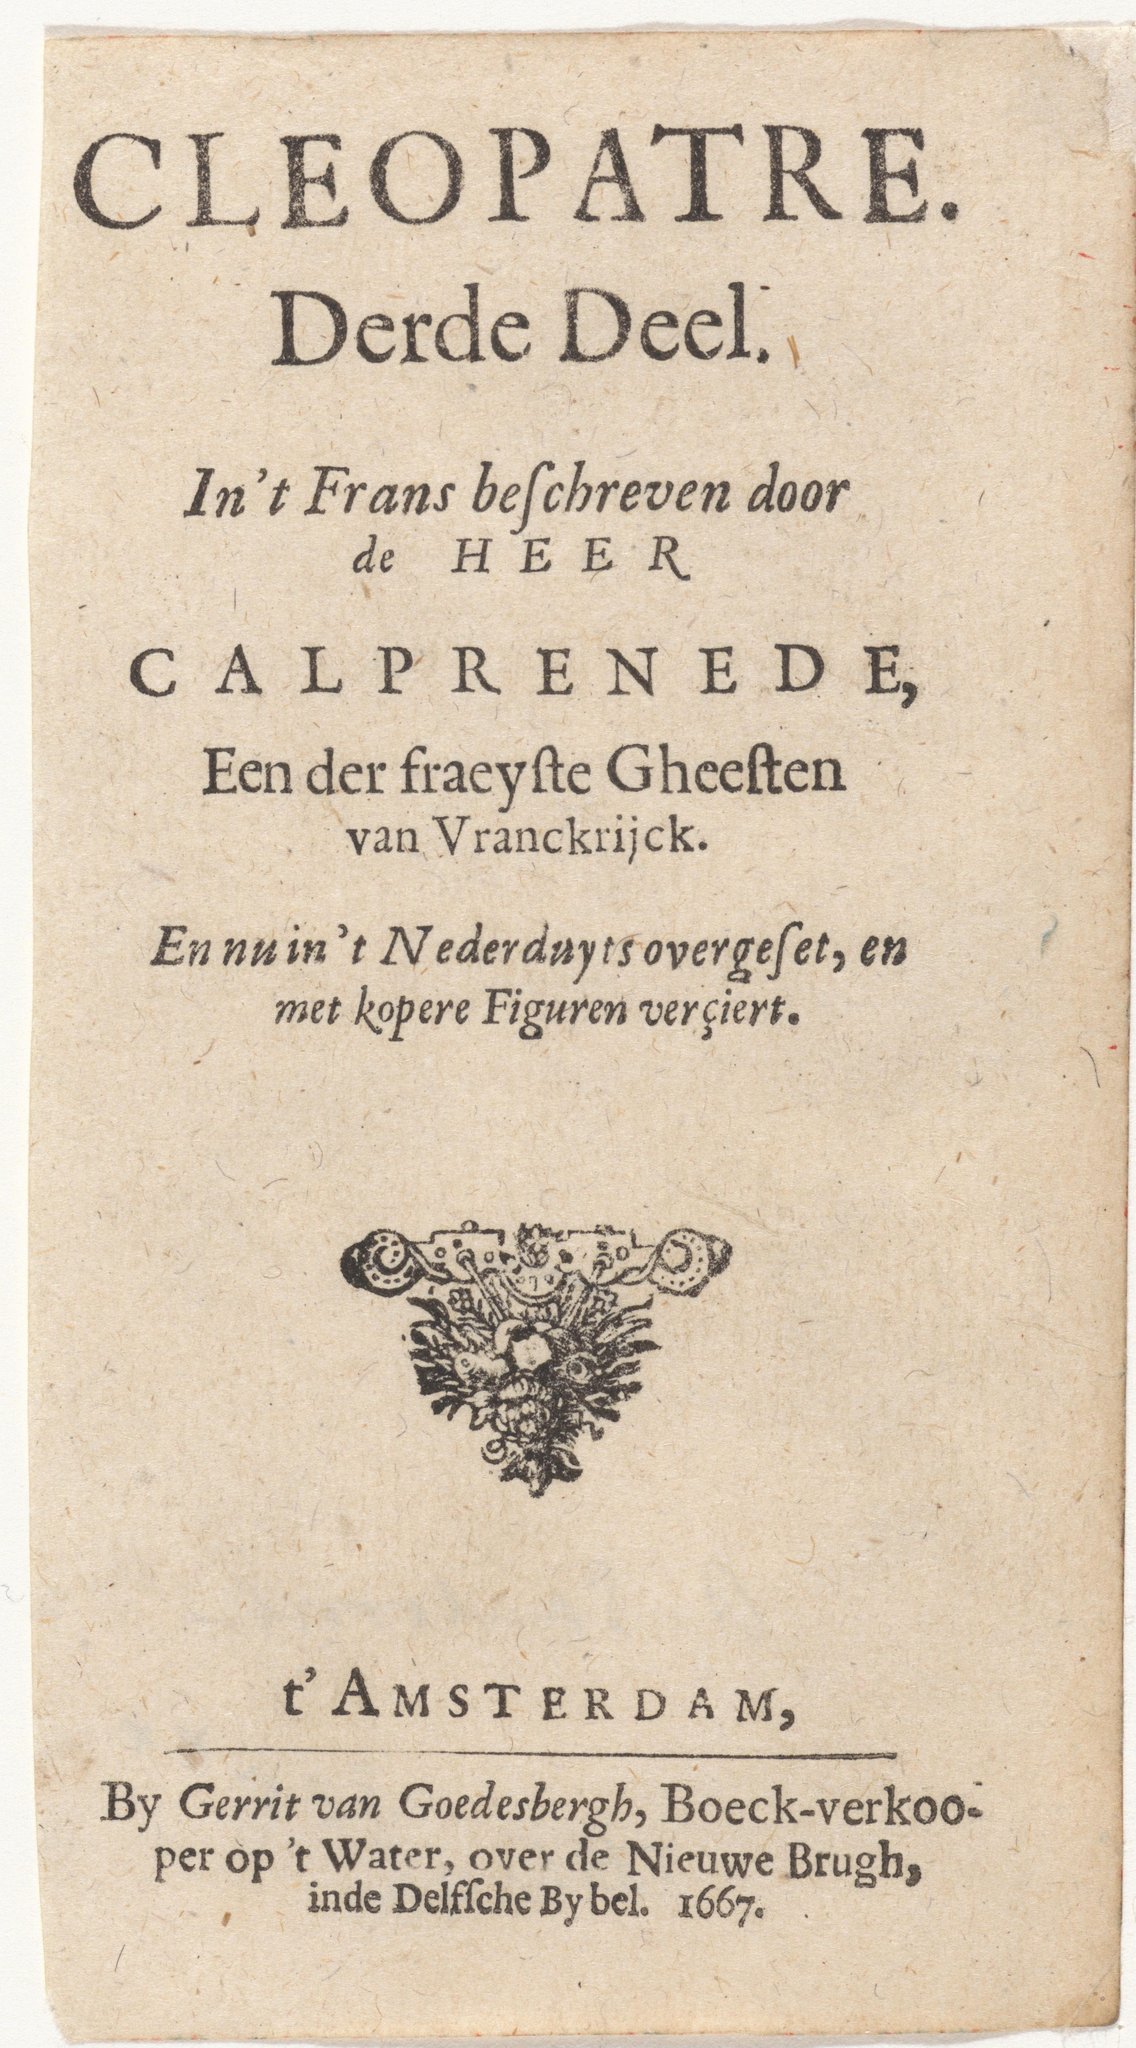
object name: print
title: Titelpagina voor: Calprenède, La. Cleopatre. Derde deel (...), 1667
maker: gerrit van goedesberg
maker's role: publisher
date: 1667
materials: paper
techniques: letterpress printing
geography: amsterdam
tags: floral interlace ~ ornament, title-page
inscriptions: collector's mark: Lugt 2228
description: Titelpagina voor: Calprenède, La. Cleopatre. Derde deel..., Amsterdam: Gerrit van Goedesberg, 1667